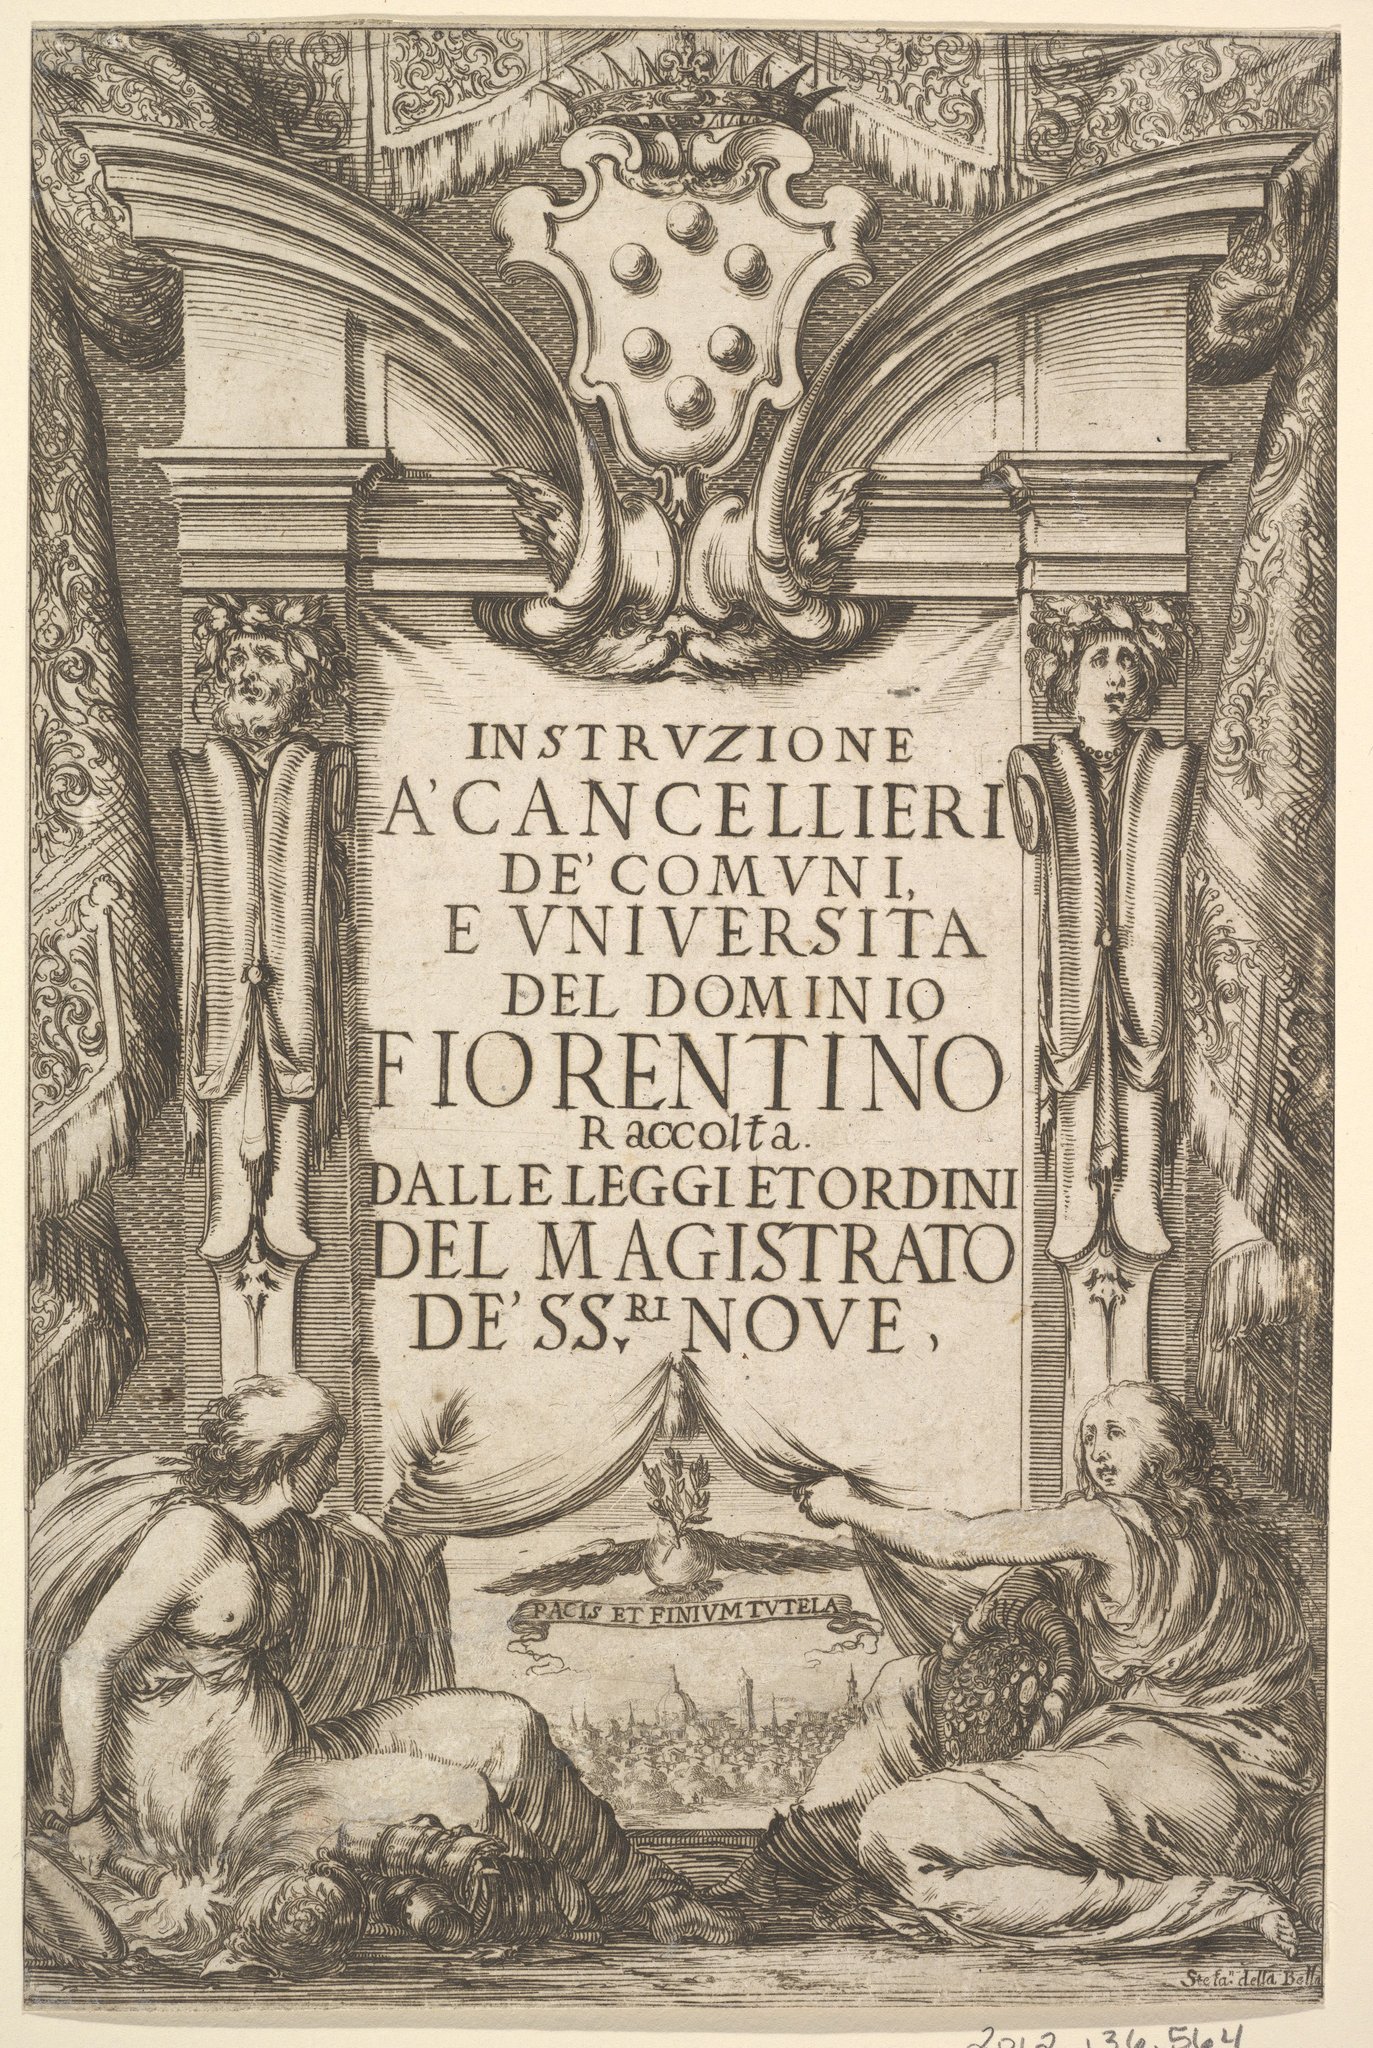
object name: print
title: Frontispiece for "Instructions for Chancellors" (Instruzione a' Cancellieri)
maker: stefano della bella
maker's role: artist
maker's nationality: italian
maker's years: 1610-1664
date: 1635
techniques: etching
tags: women,coat of arms